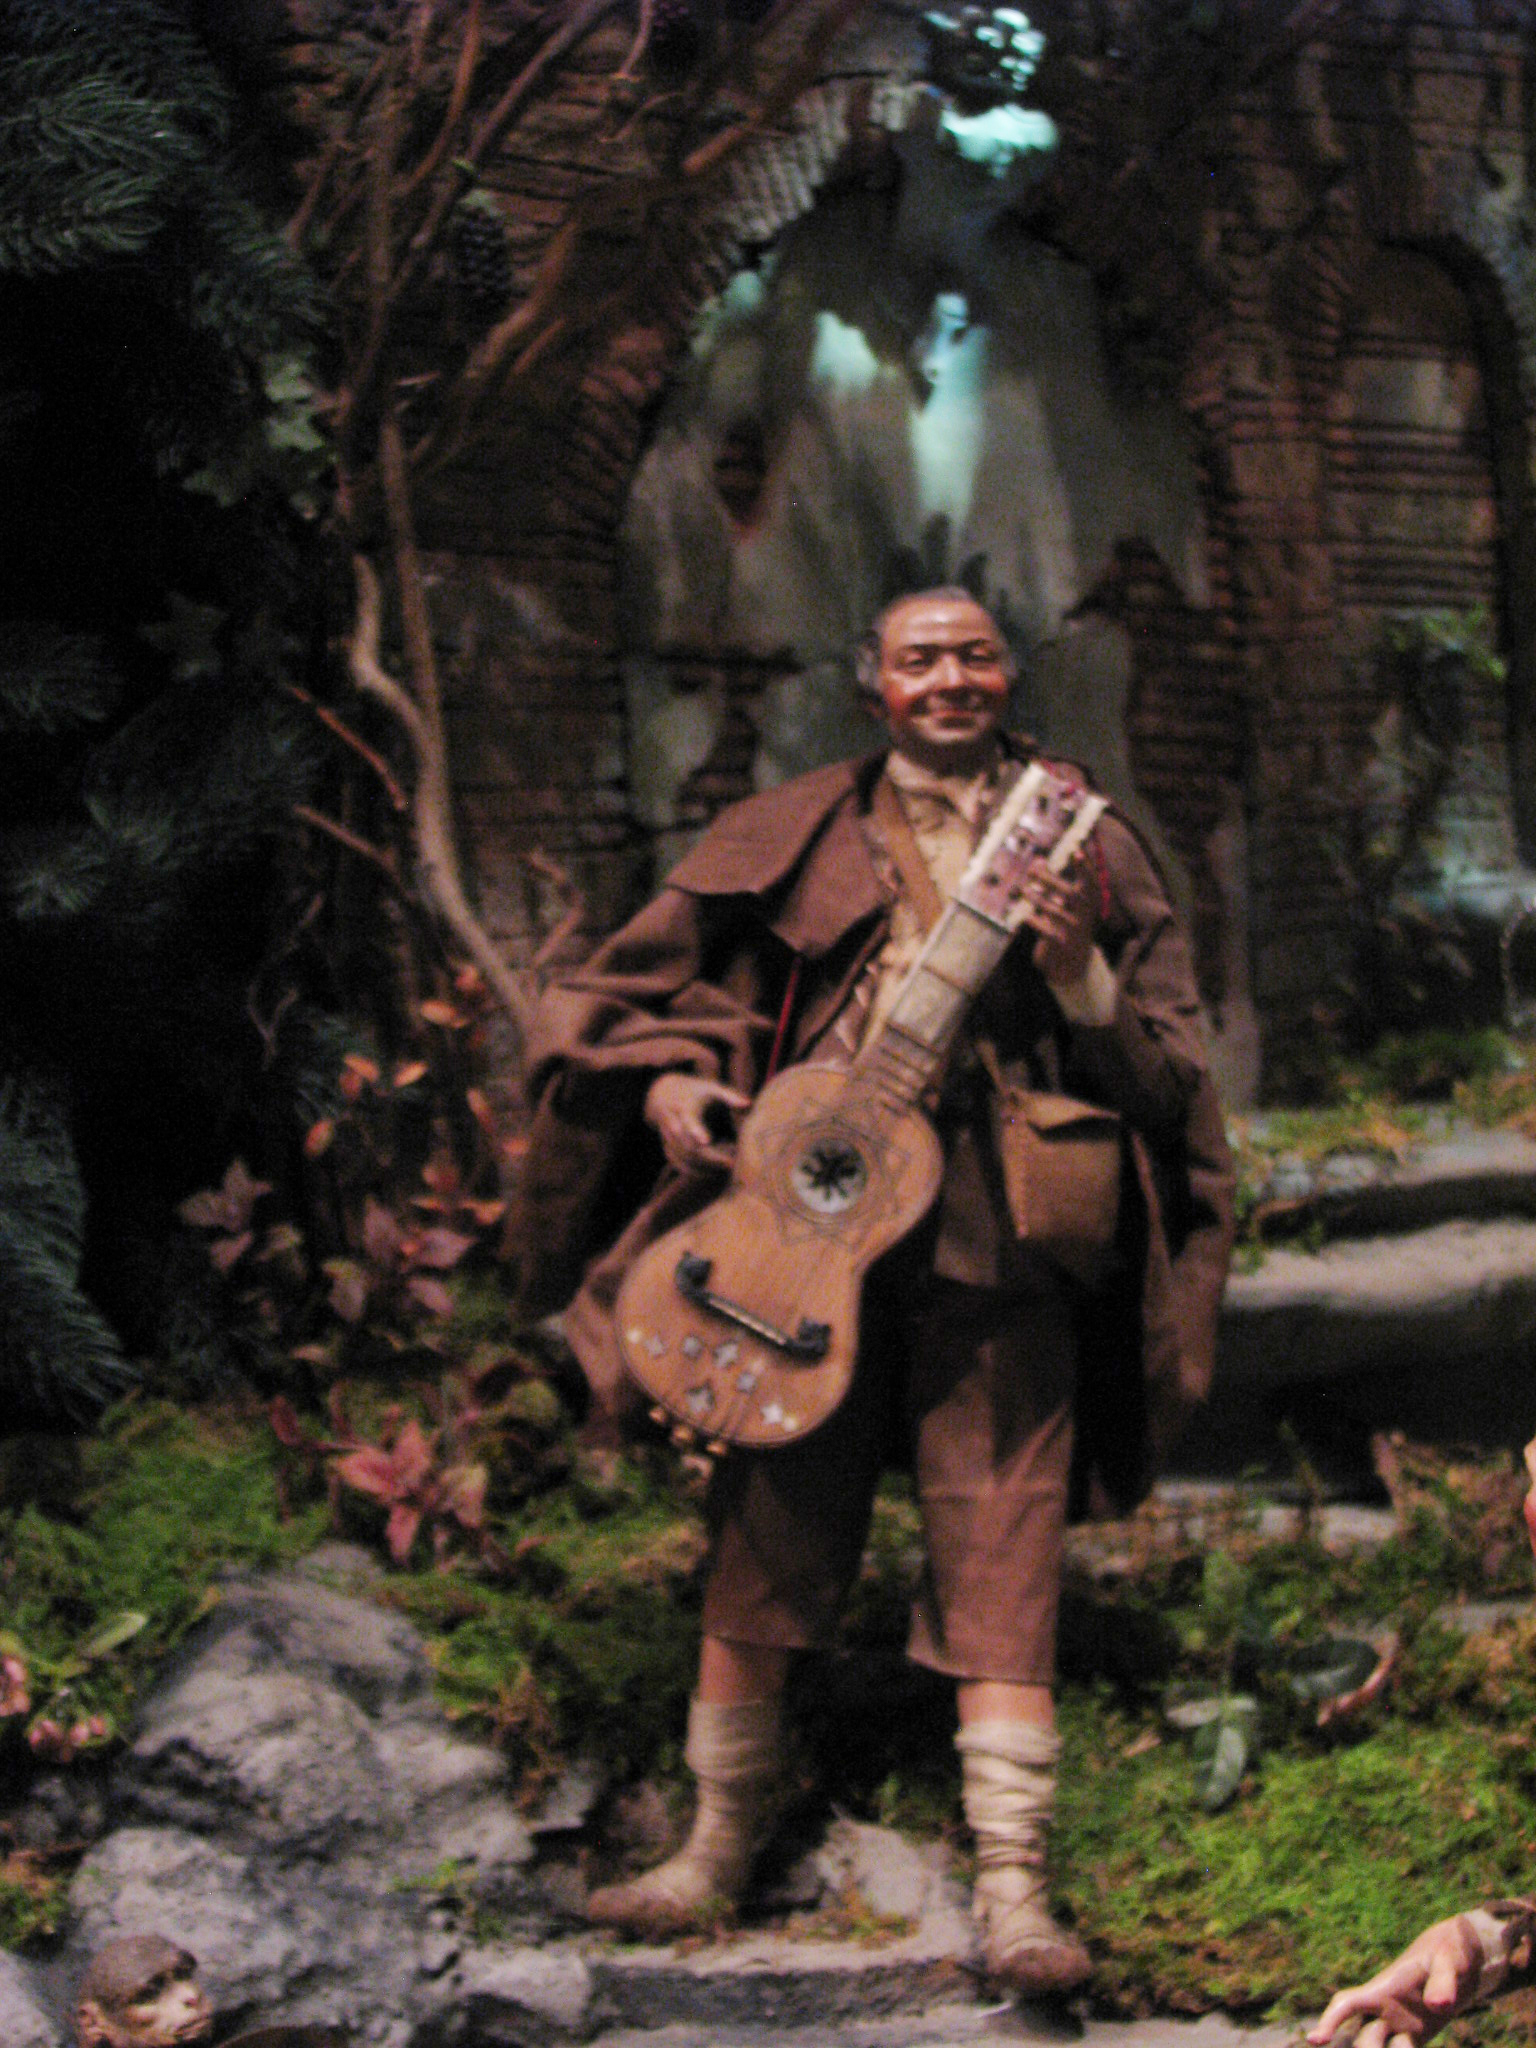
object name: crèche figure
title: Guitarist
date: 1701-1800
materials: cotton, leather, shell, terracotta, fiber, metal, wood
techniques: inlay, polychrome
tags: hands,men,guitars,plants